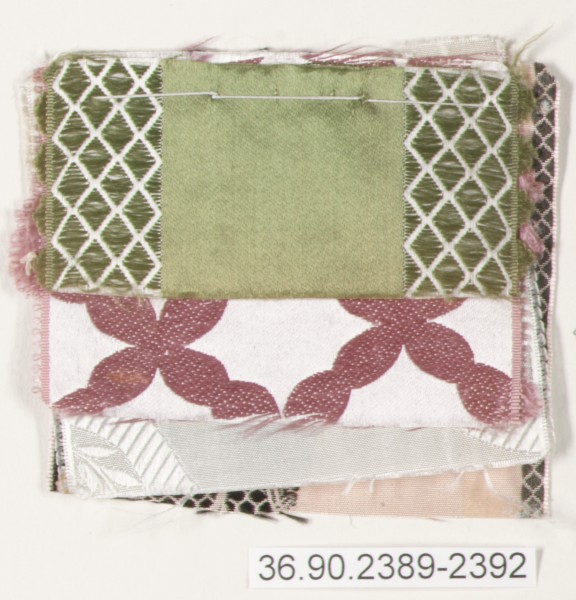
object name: ribbon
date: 1801-1900